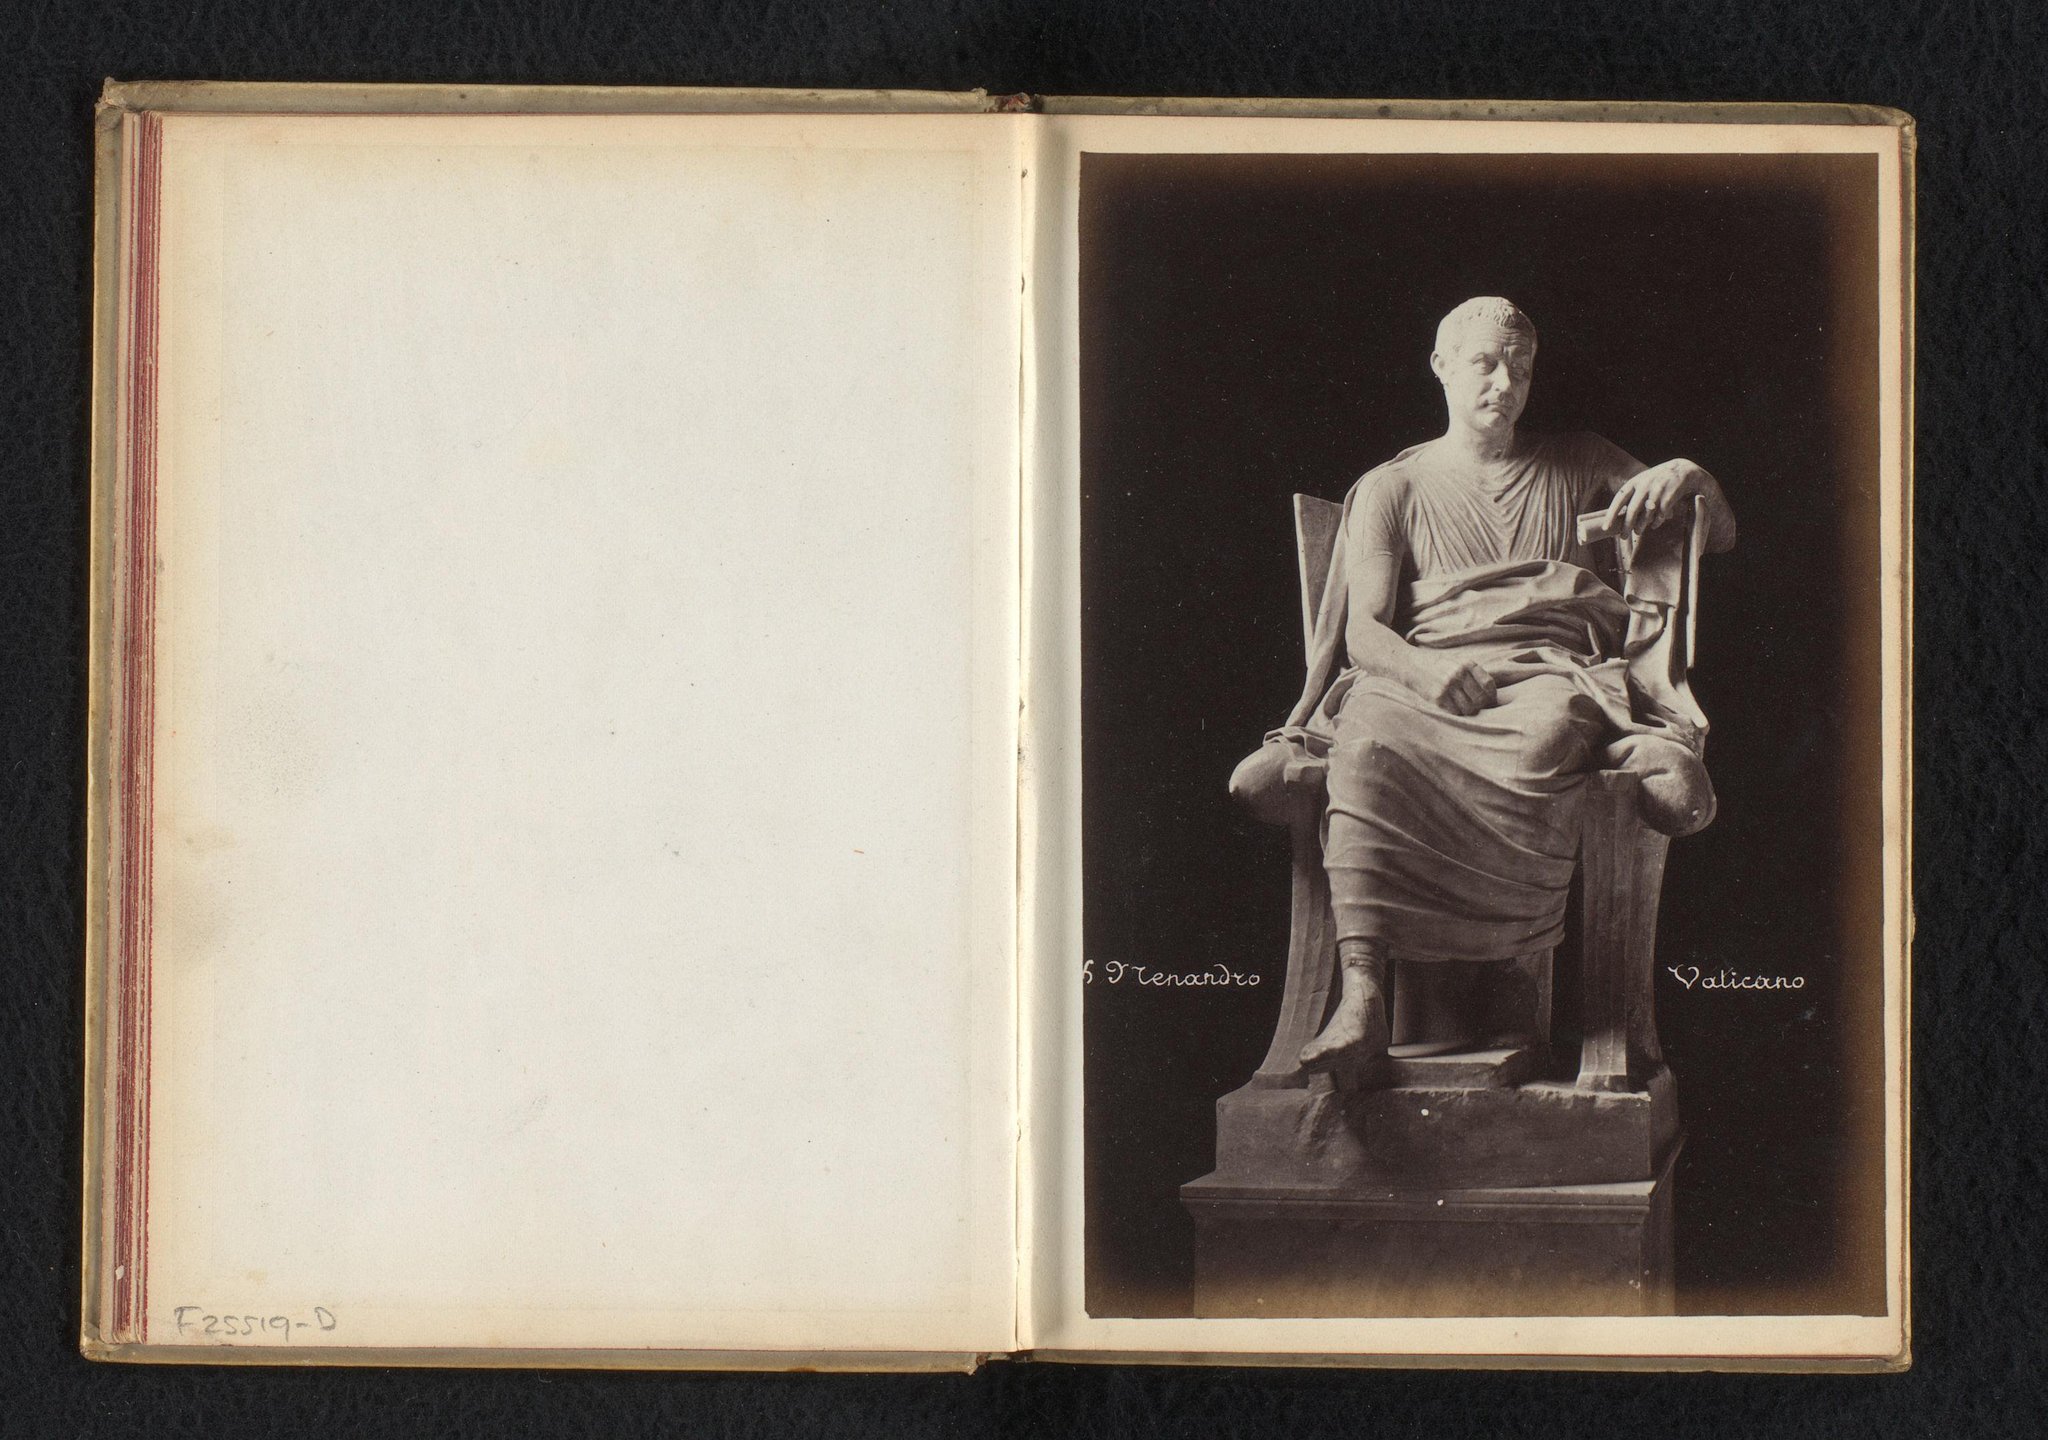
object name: page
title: Standbeeld van Menander in de Vaticaanse Musea, Vaticaanstad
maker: Anonymous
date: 1851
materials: paper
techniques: albumen print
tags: piece of sculpture, reproduction of a piece of sculpture, writer, poet, author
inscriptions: number: ‘6’